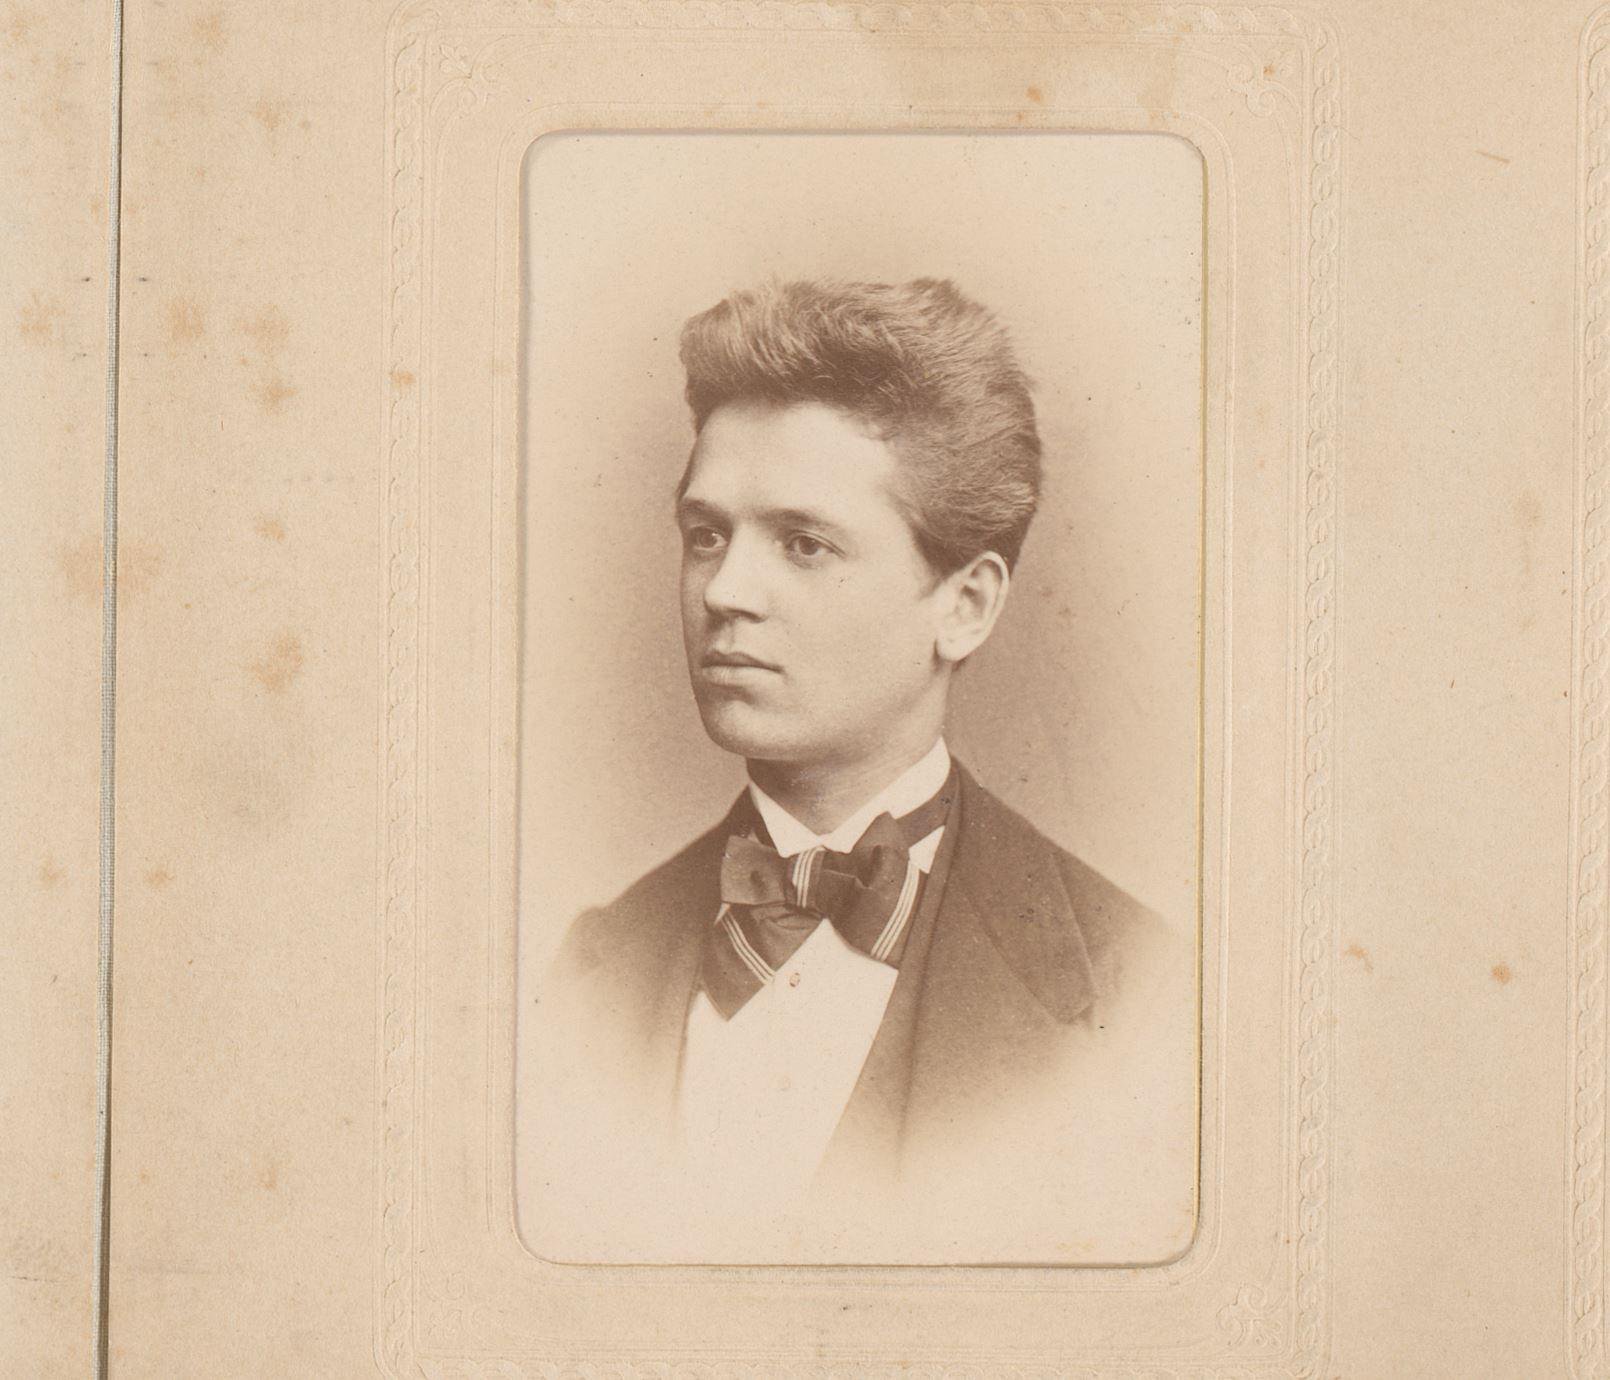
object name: carte de visite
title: Portret van een jonge man met vlinderstrik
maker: j. tomáš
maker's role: fotograaf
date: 1872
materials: cardboard, photographic support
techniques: albumen print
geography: prague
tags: historical persons, youth, adolescent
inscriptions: annotation: ‘v. Praze 18 15/8/ 72’, inscription: ‘J. TOMÁŠ/ fotograf a techn. lucebnik/ sv. Vacslavske námesti/ v/ PRAZ/ cislo/ Fotograf u. techn. Chemikrn/ St. Wenzels Platz/ in/ PRAG/ Nro/ 7./’